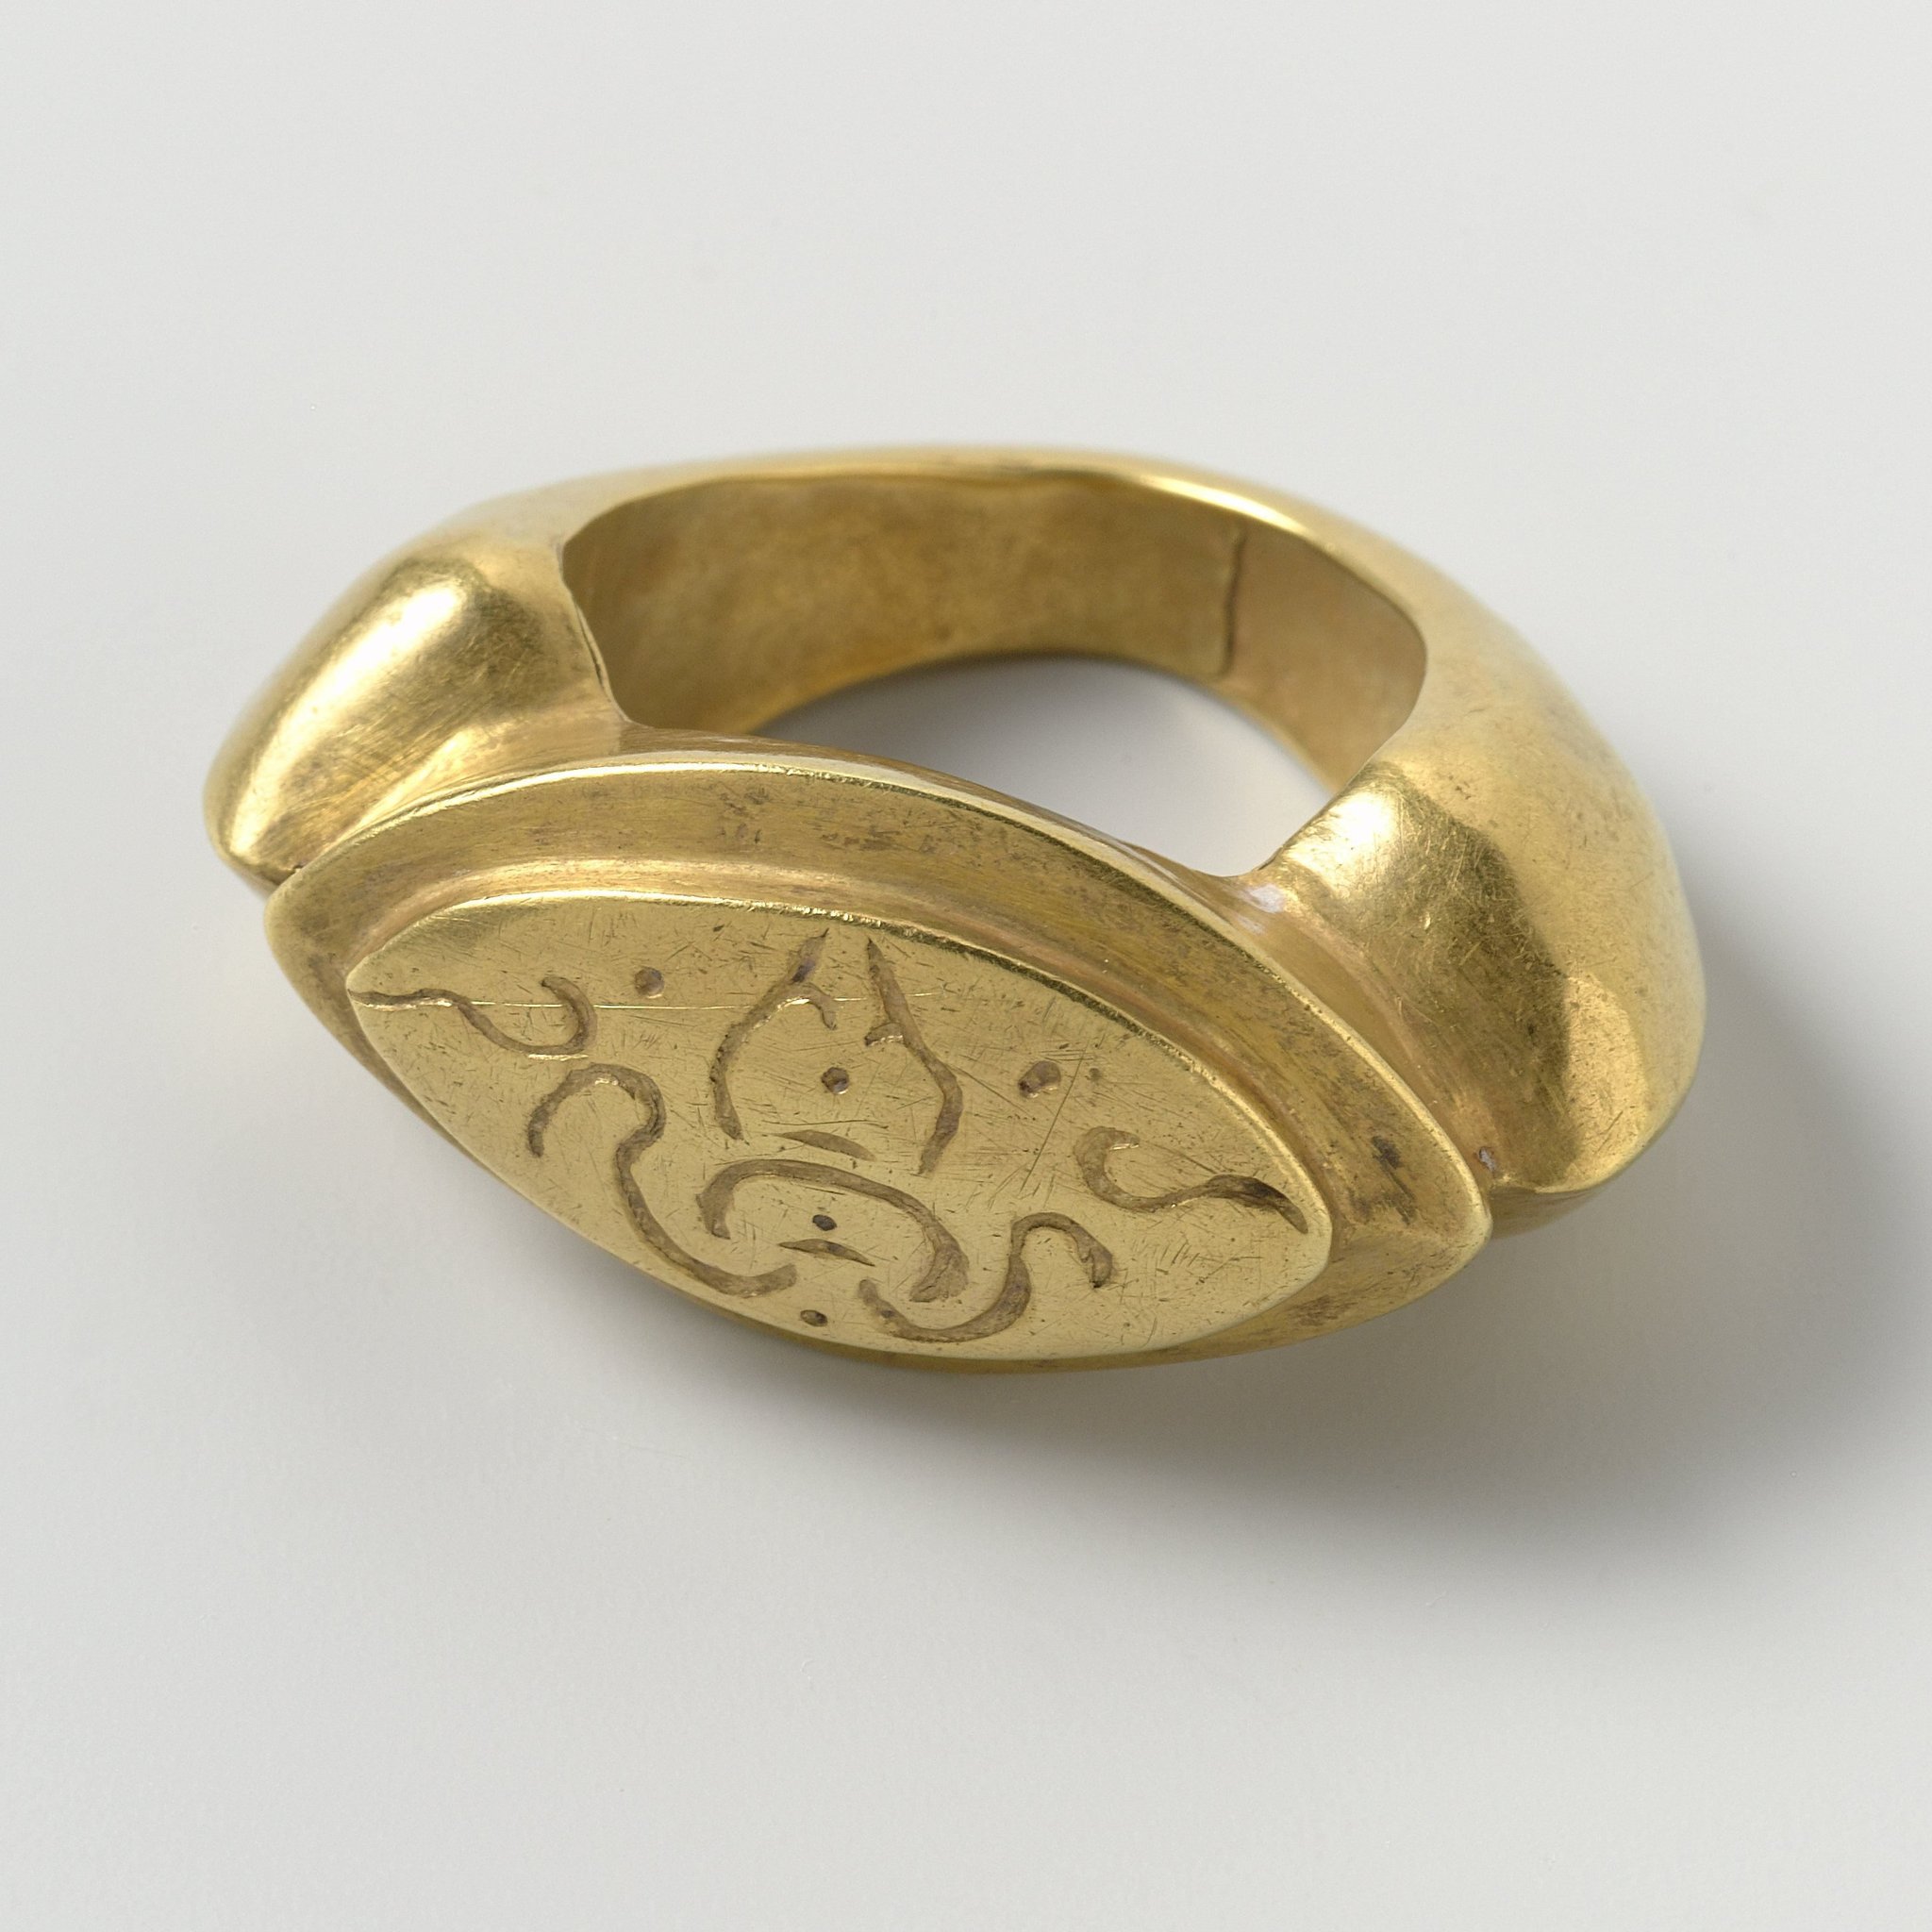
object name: ring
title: Ring with shri symbol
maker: Anonymous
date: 800-1200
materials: gold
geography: indonesia